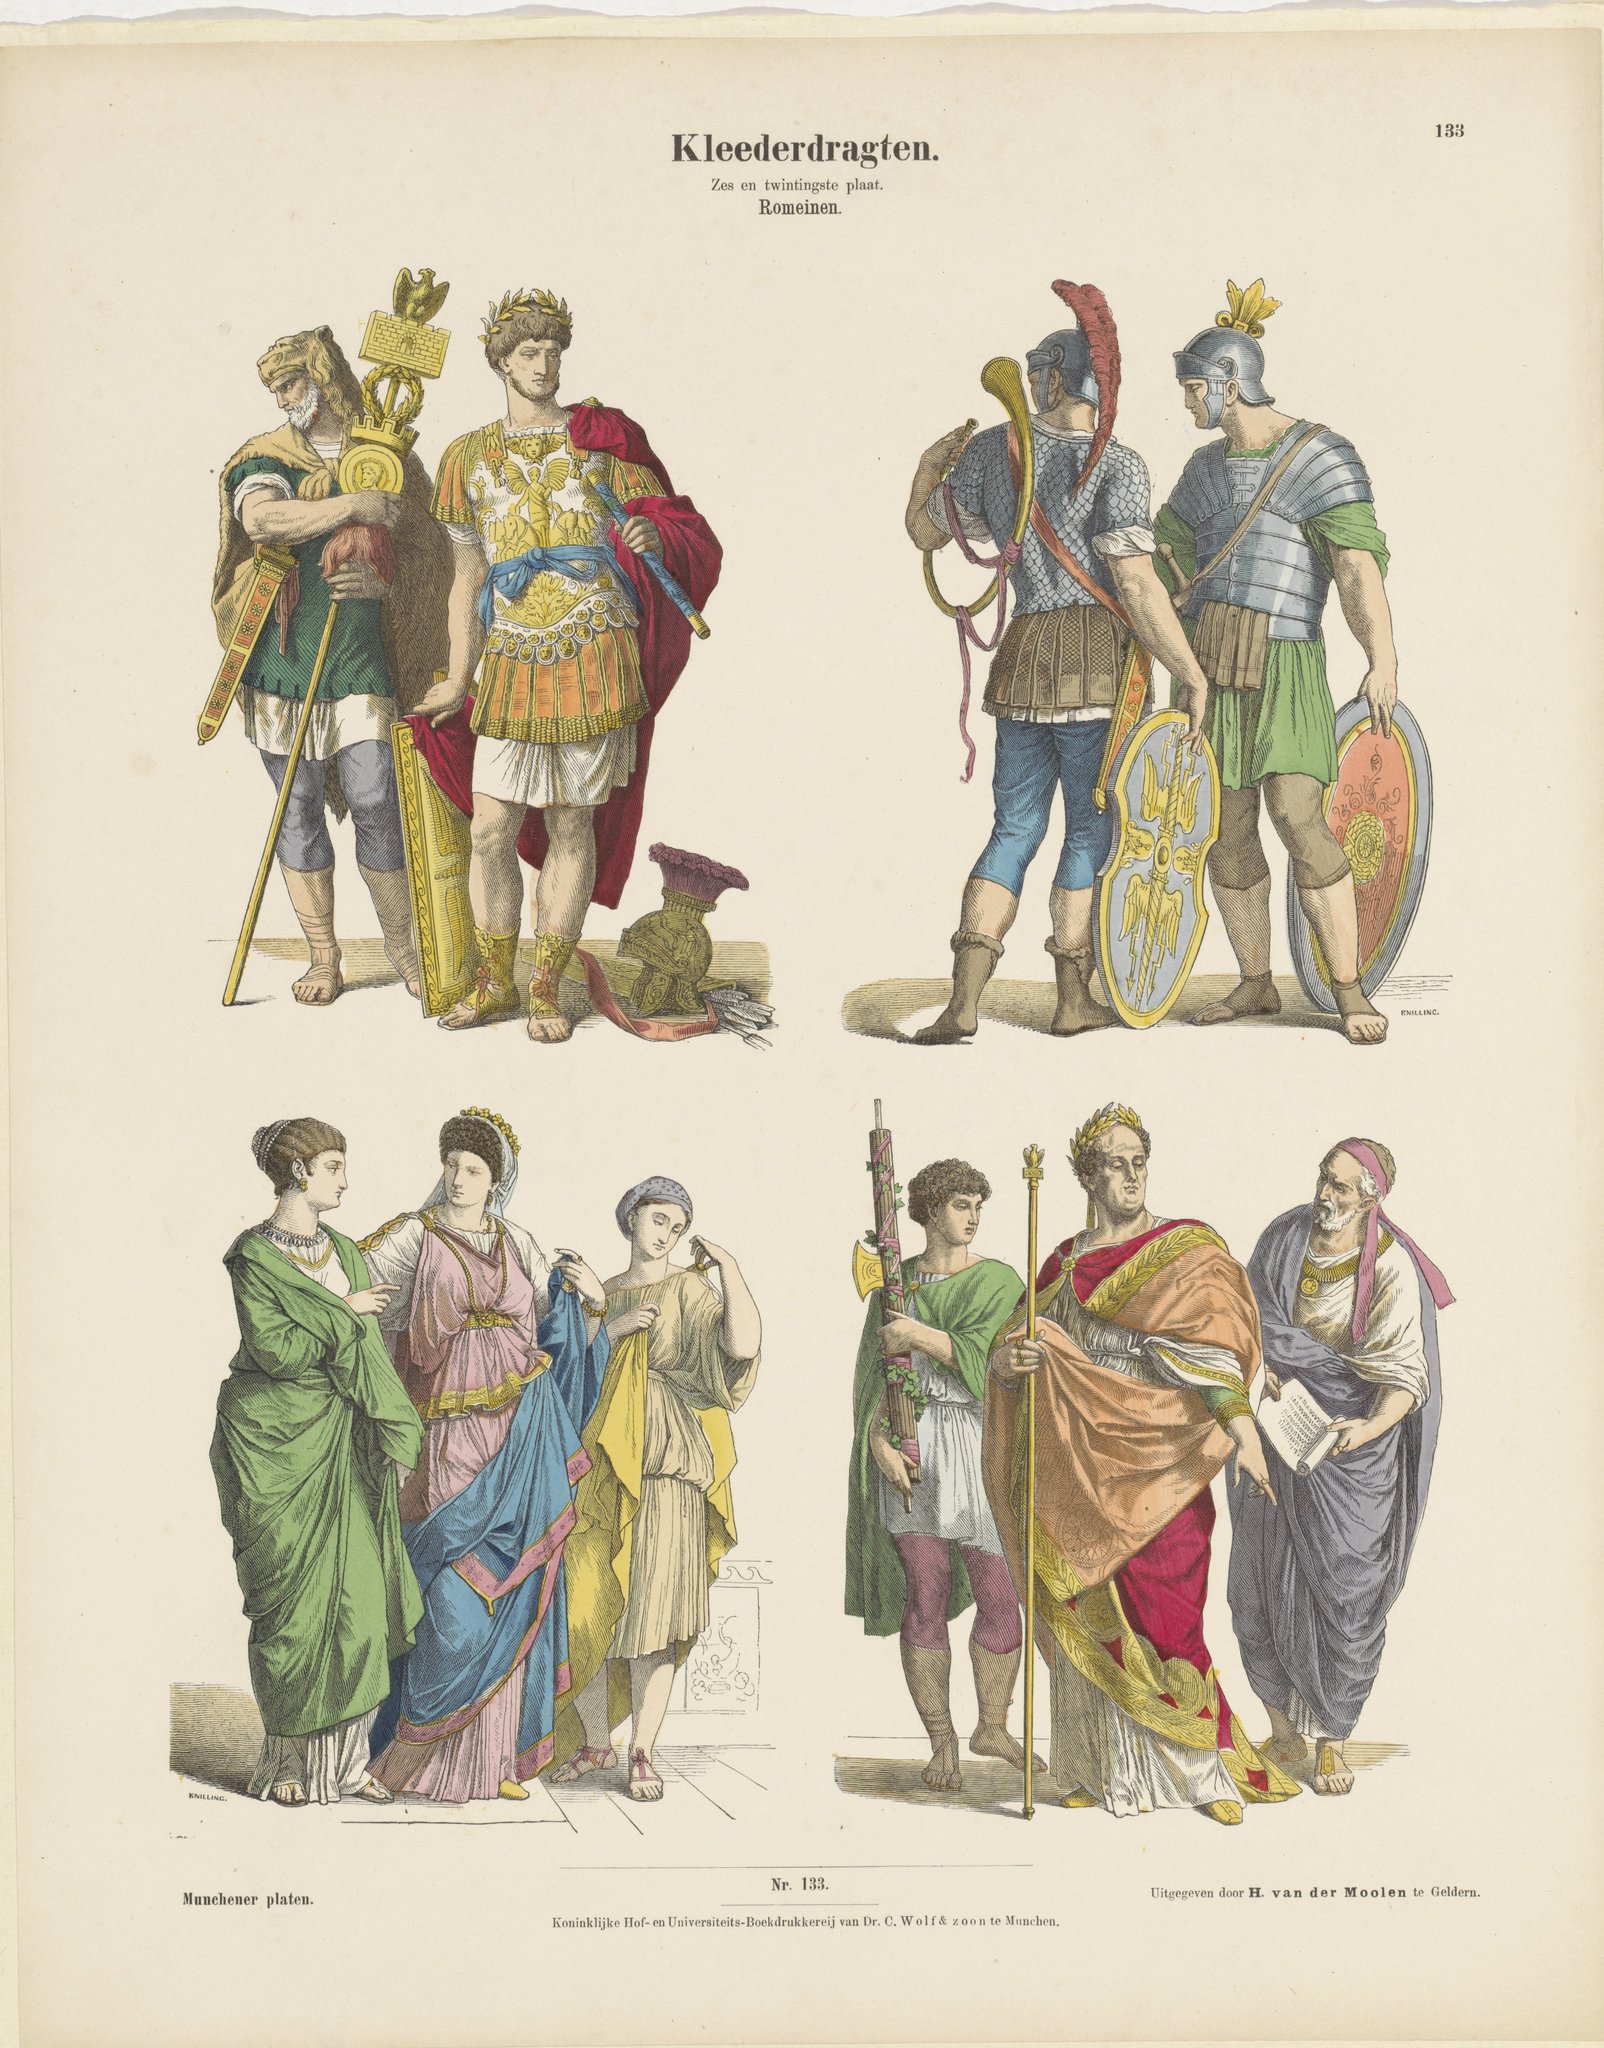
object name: print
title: Munchener platen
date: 1843-1920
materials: paper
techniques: colour, letterpress printing, engraving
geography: geldern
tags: historical costume, folk costume, regional costume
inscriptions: collector's mark: Lugt 2760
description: Nederlandse editie van een prent uit de reeks "Munchener platen" uitgegeven door K. Braun & Fr. Schneider te München met het adres van wederverkoper Hermann van der Moolen.